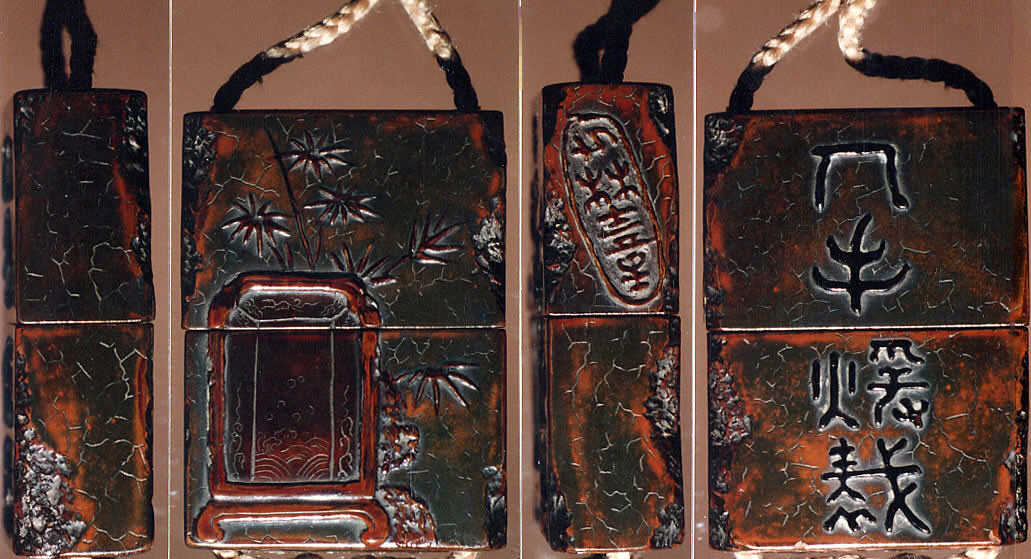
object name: inrō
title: Case (Inrō) with Design of Screen (Tsuitate) with Wave Decoration and Inscriptions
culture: japanese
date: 1701-1800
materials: lacquer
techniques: fundame, hiramakie, roiro, maki-e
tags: plants,screens